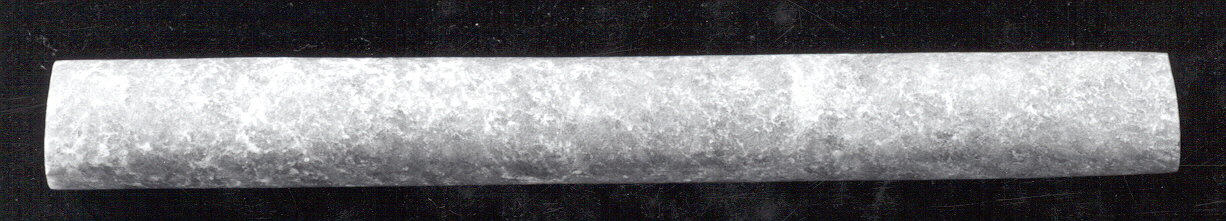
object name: bead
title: Tubular Bead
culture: atlantic watershed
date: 301-800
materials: jade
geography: costa rica